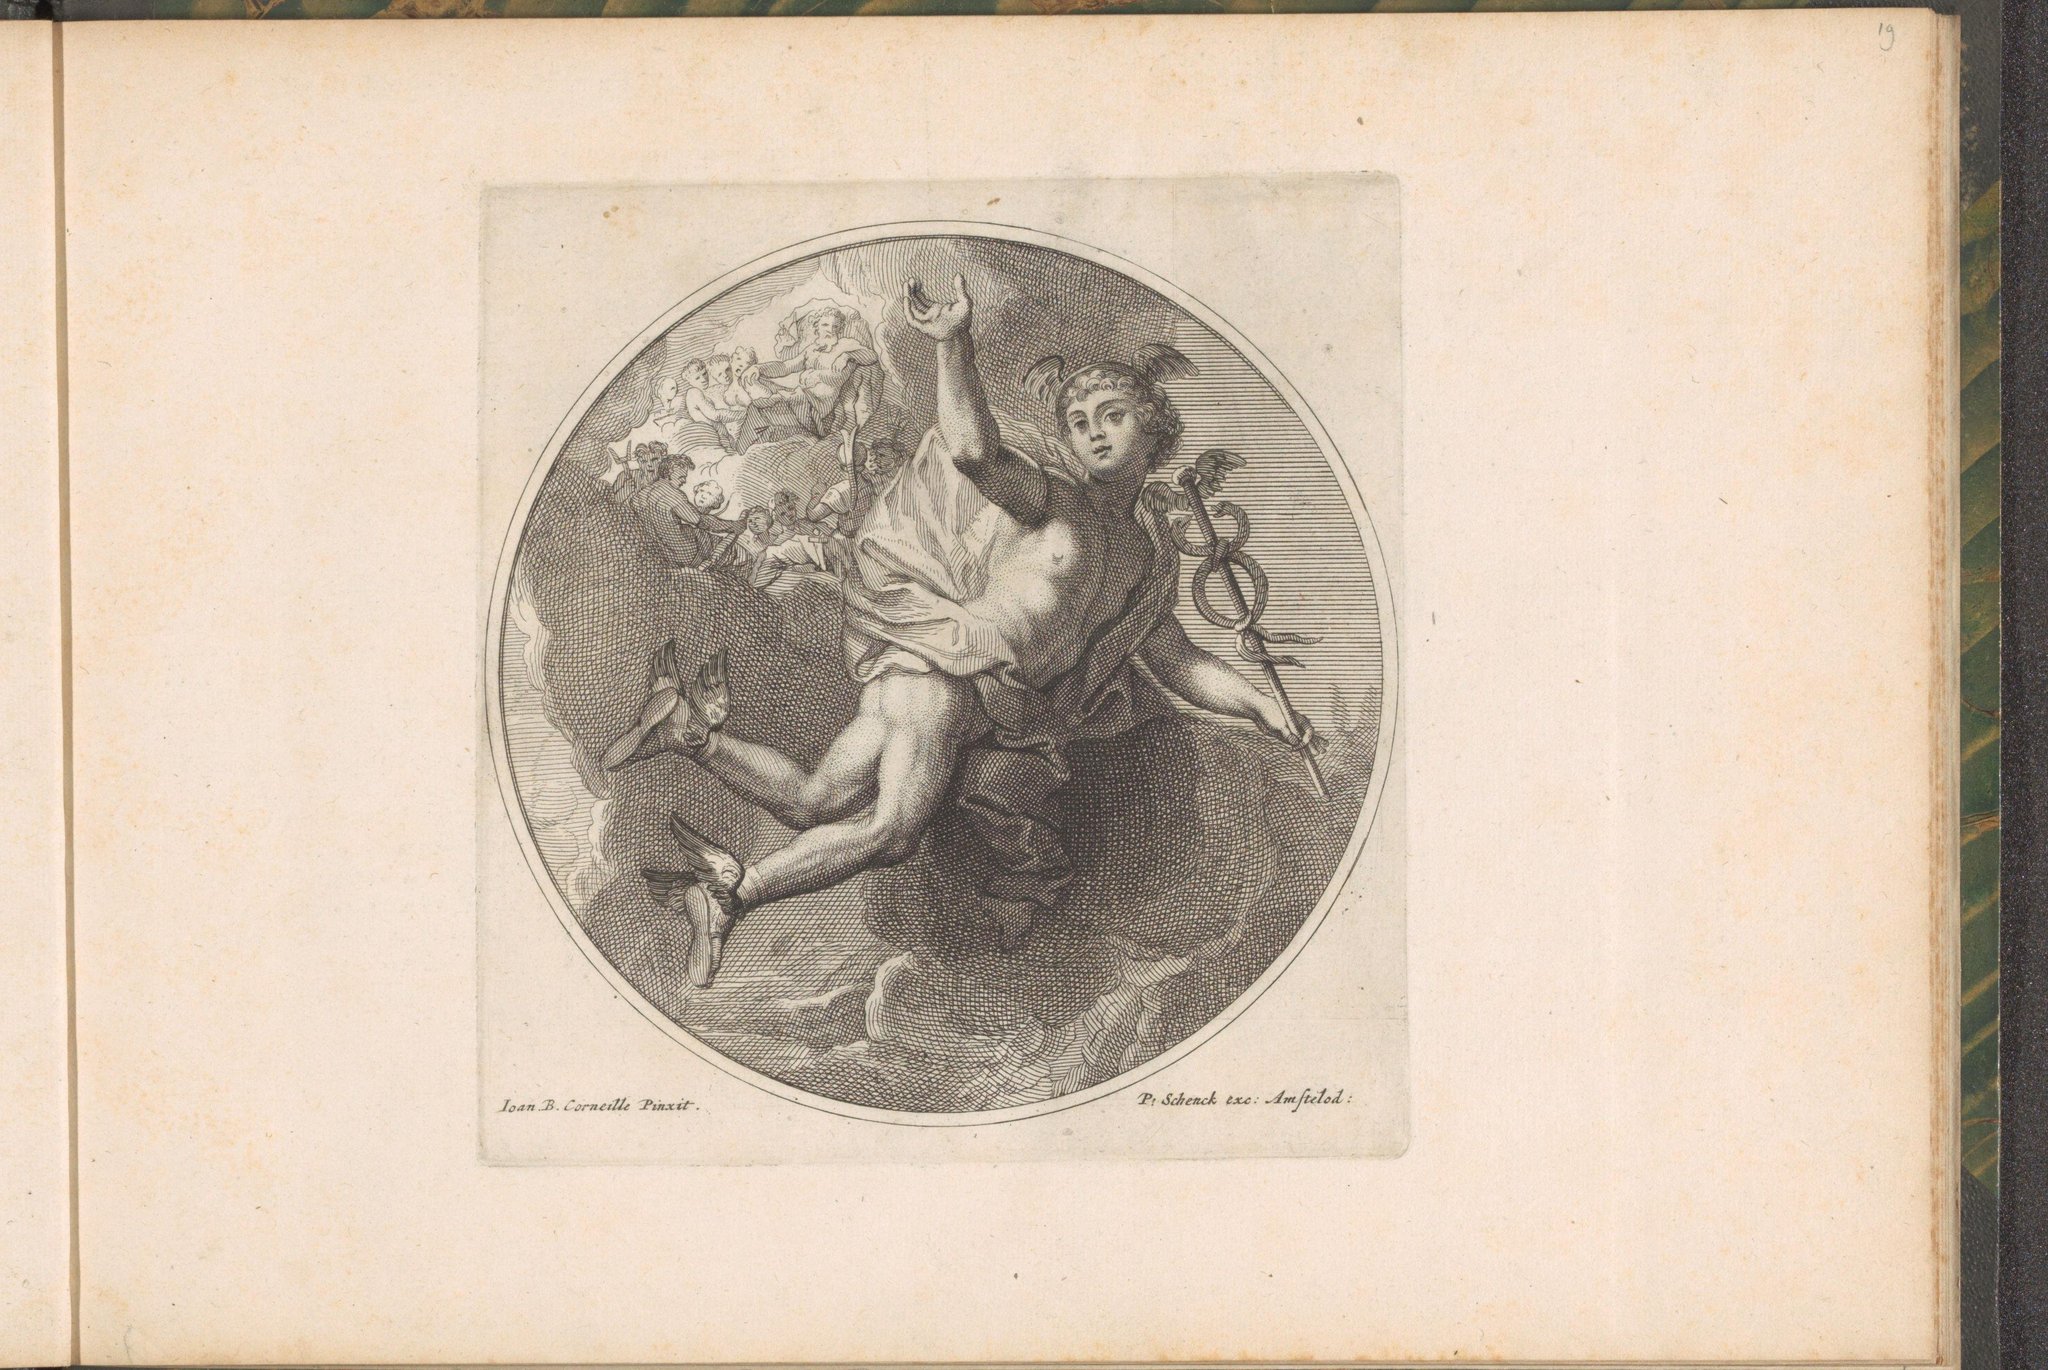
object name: print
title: Mercurius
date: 1693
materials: paper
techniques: engraving, etching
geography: amsterdam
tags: (story of) mercury (hermes), (decorated) ceiling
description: Plafondstuk met de god Mercurius, vliegend met de caduceus in zijn hand. Op de achtergrond de goden van de Olympus op de wolken. Prent maakt deel uit van een album.